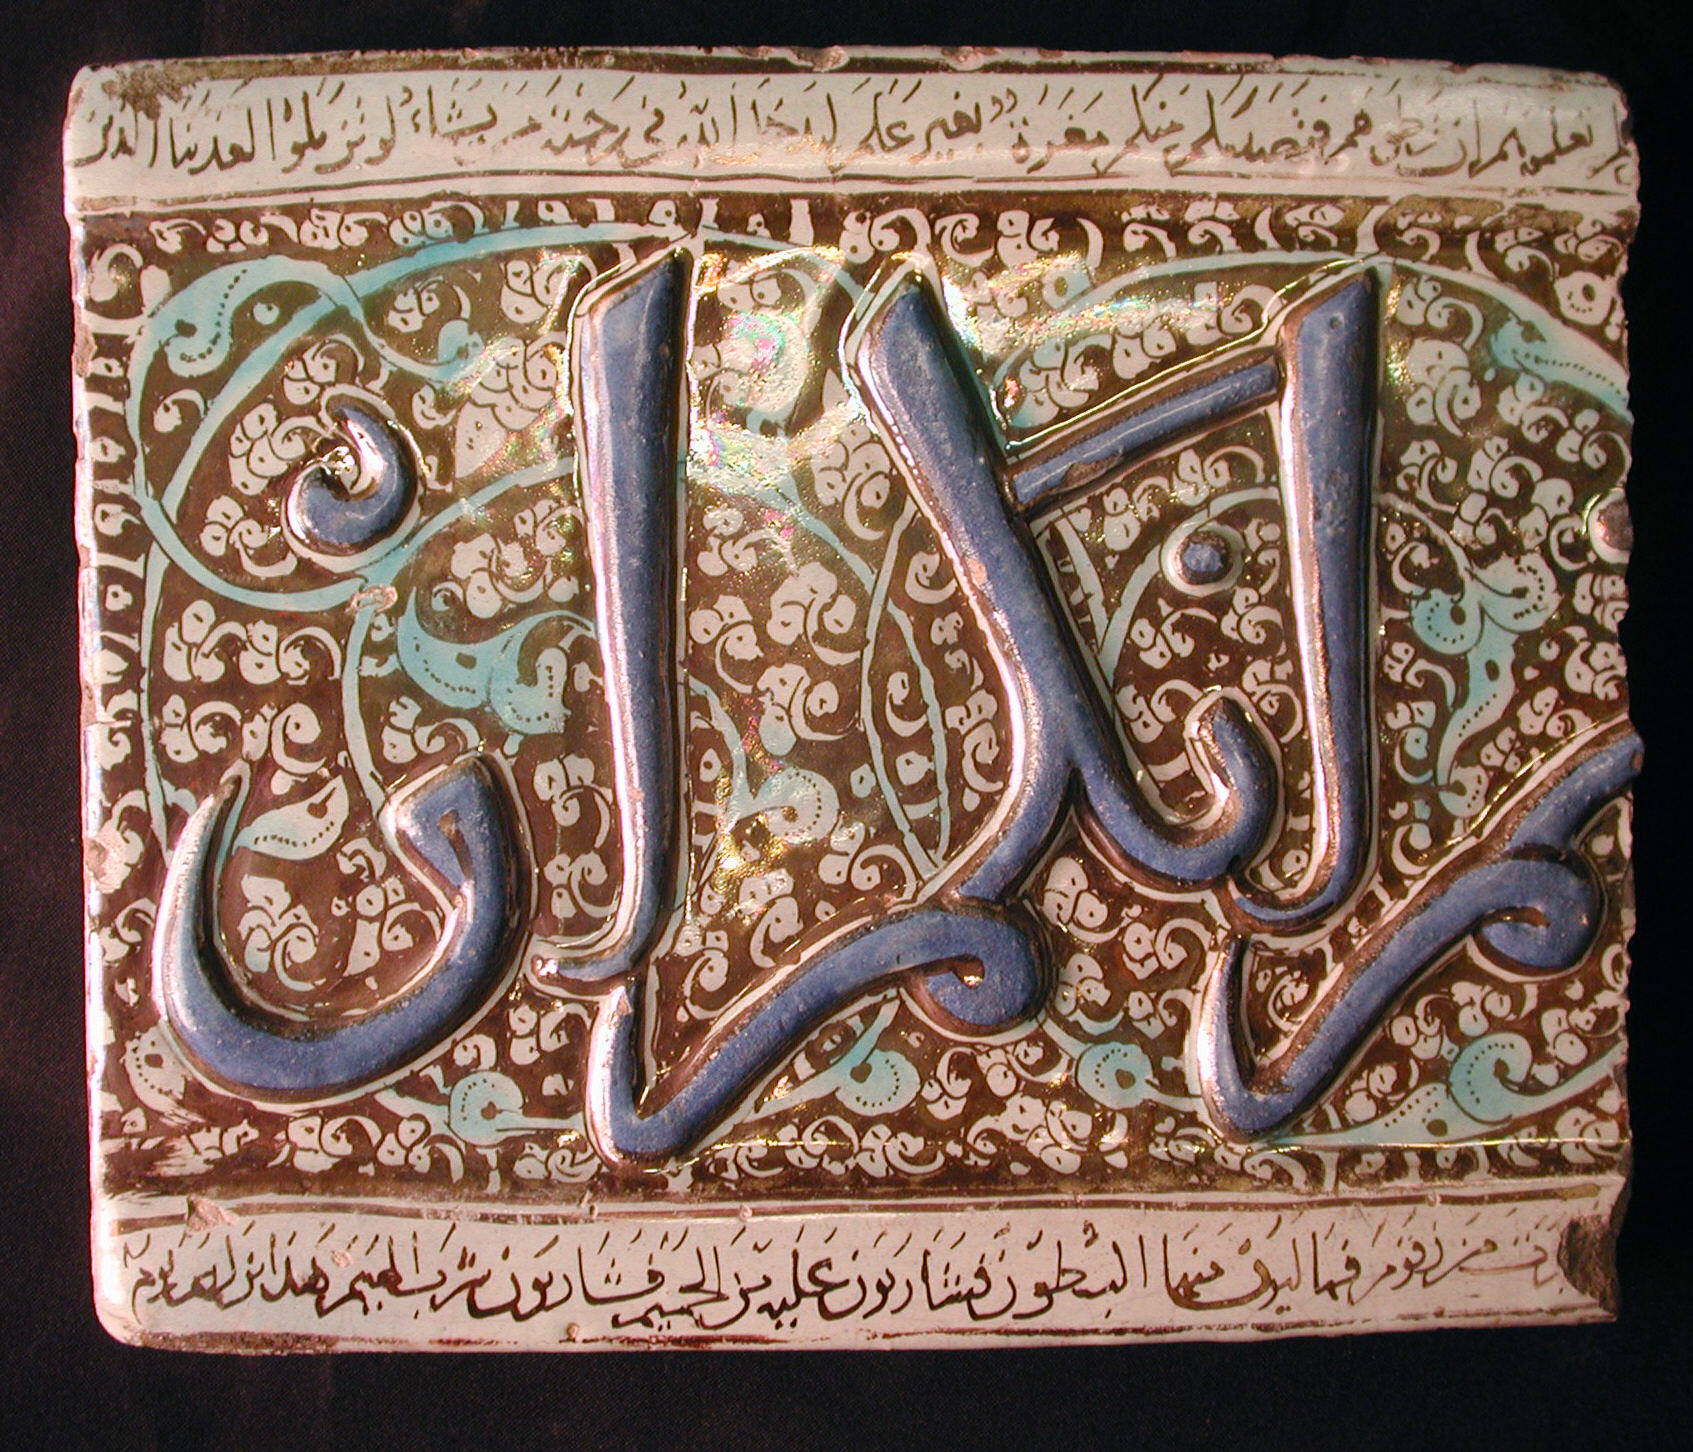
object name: tile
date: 1301-1333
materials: glaze, stonepaste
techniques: luster painting, painting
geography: iran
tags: arabic